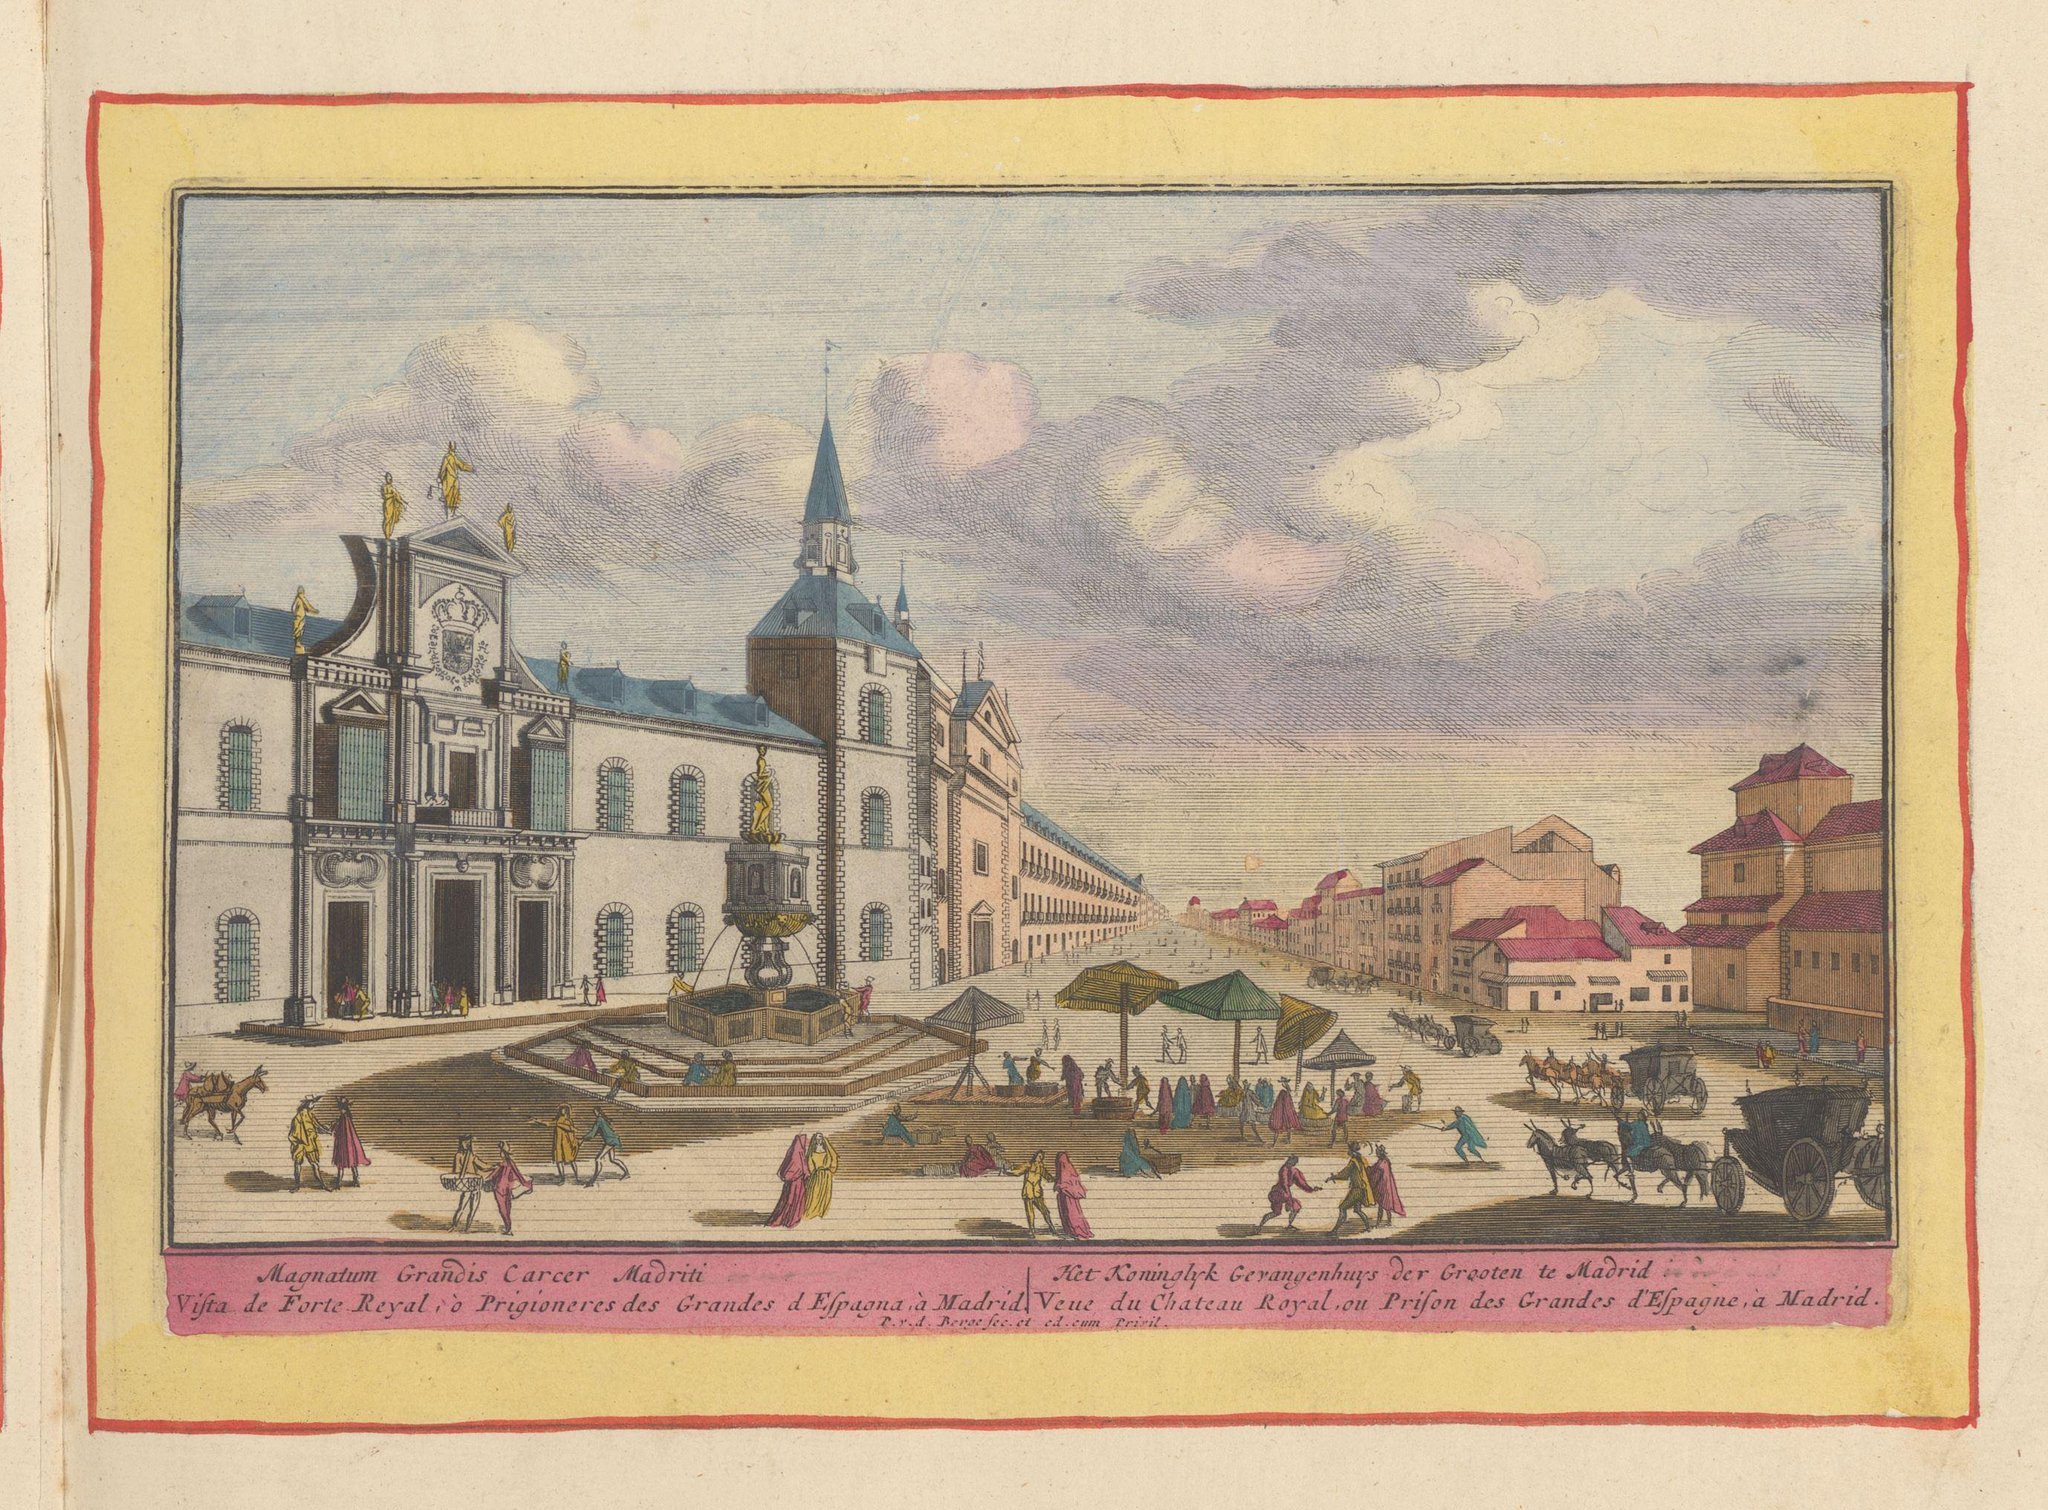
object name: print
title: Koninklijke gevangenis te Madrid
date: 1694-1737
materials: paper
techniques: etching, hand coloring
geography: amsterdam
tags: prison, jail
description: Prent uit: Theatrum Hispaniæ, exhibens regni urbes, villas ac viridaria magis illustria. Het aanmerkelykste en voortreffelykste in Spanjen (...). Amsterdam: Pieter van den Berge, ca. 1694-1737.